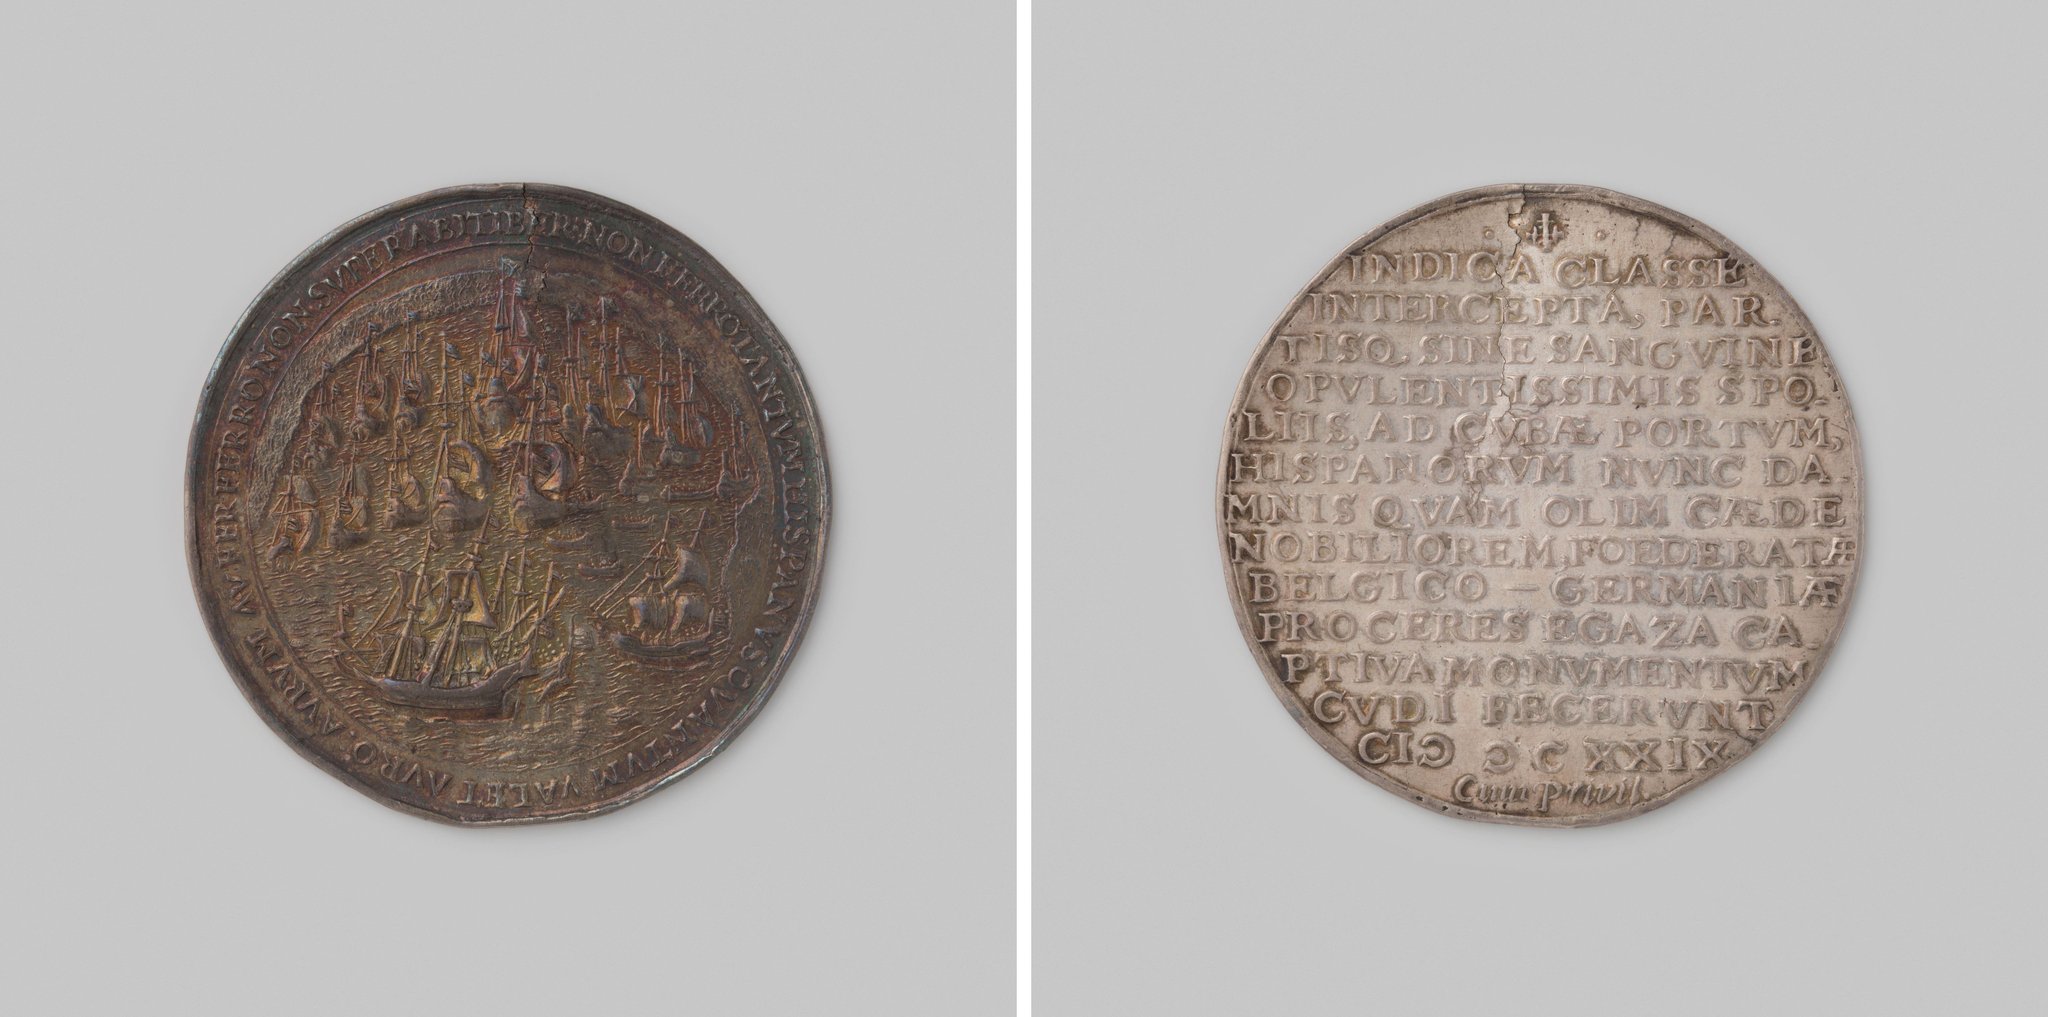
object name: history medal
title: Piet Heyn verovert de Spaanse Zilvervloot 1629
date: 1629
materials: silver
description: Zilveren penning, op de voorzijde een zeeslag in een baai, met omschrift, op de keerzijde veertien regels tekst.